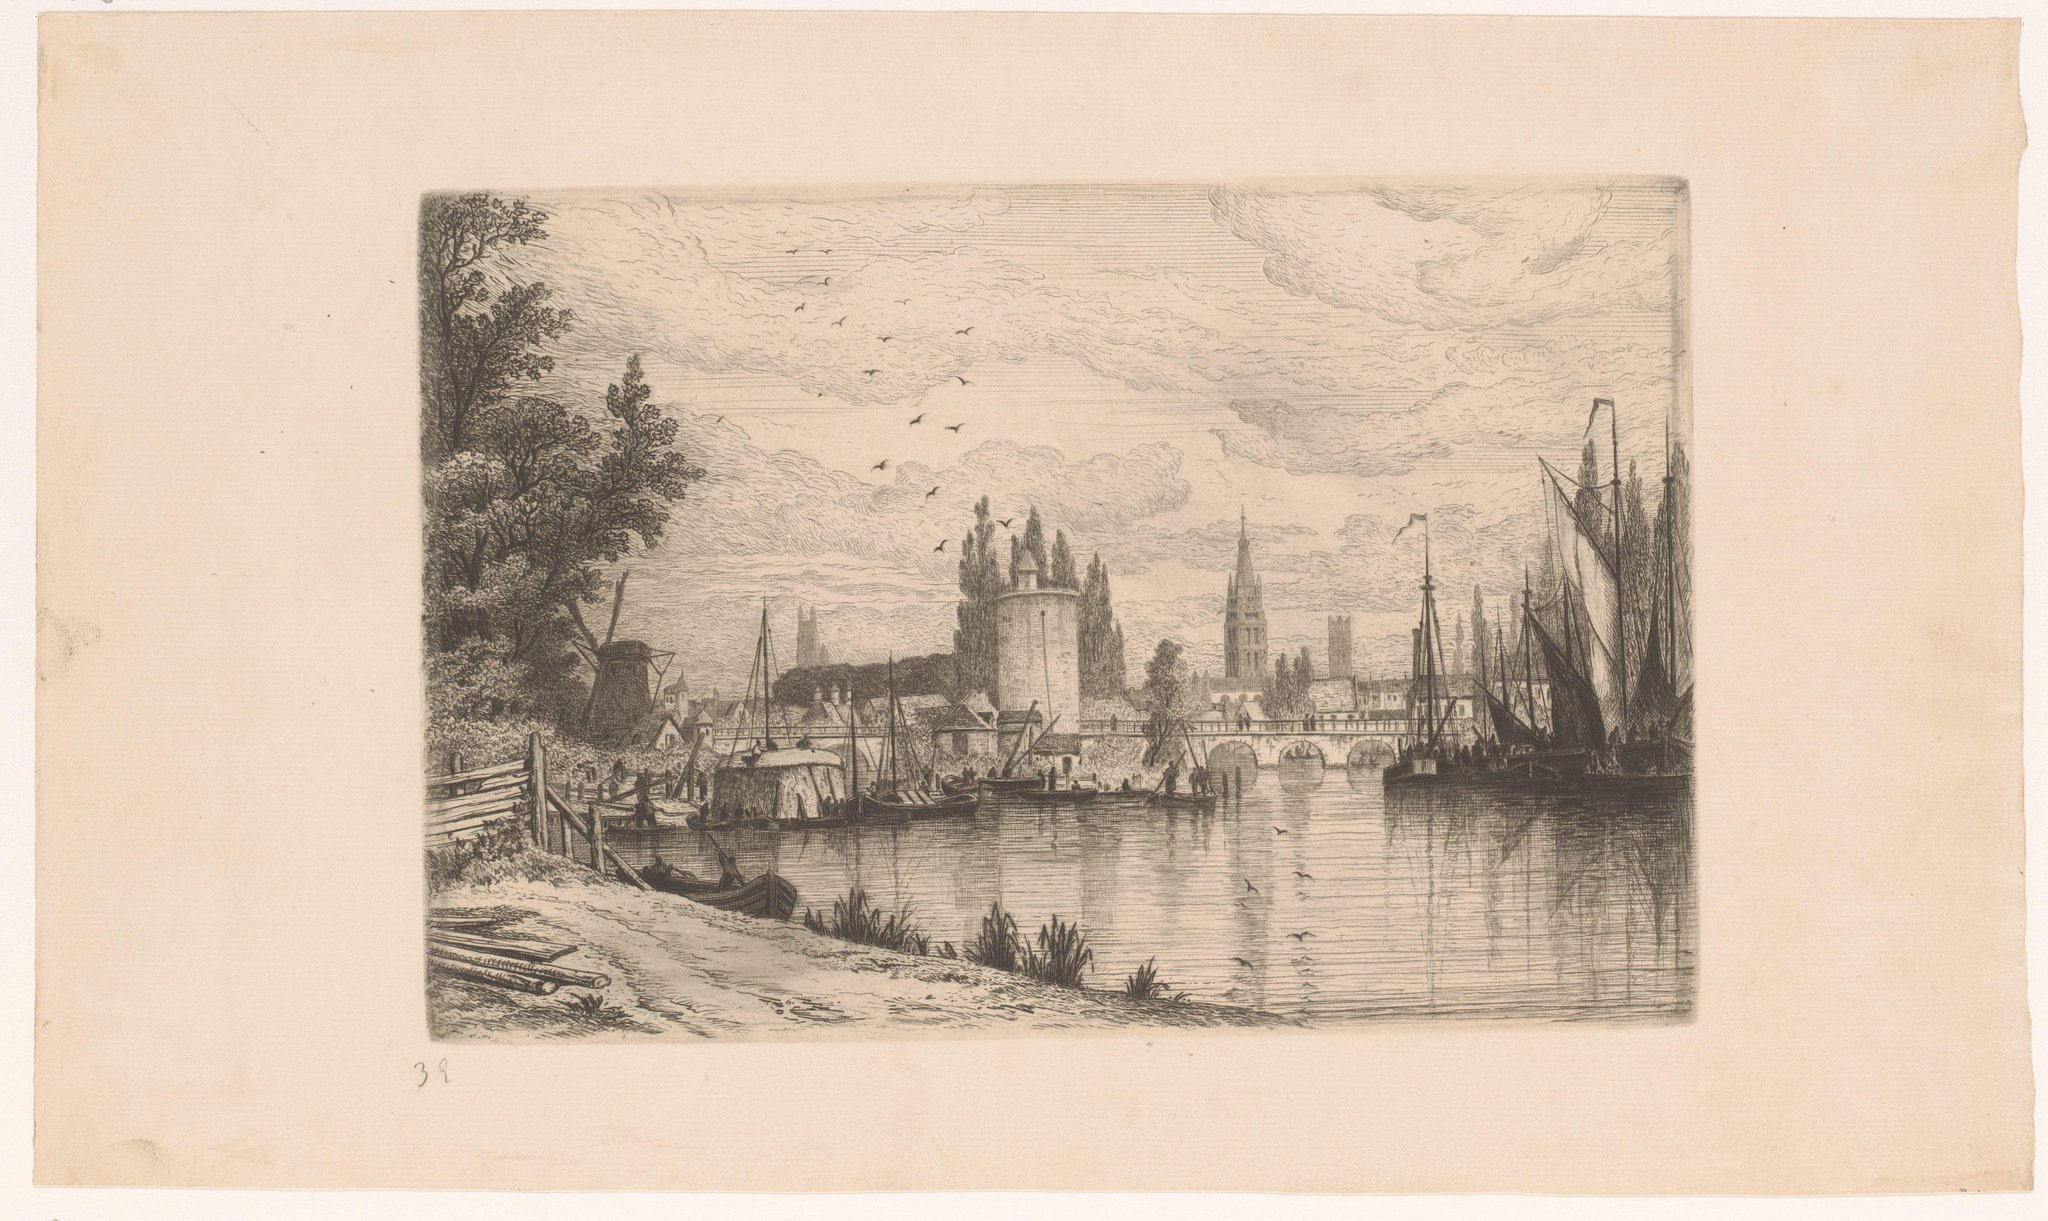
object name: print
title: Gezicht op een stad, mogelijk Brugge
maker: auguste numans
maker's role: print maker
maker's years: 1823-1883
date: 1833-1879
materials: paper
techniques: etching, intaglio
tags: harbour, city-view, and landscape with man-made constructions, bridge, bruges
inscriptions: collector's mark: Lugt 2228